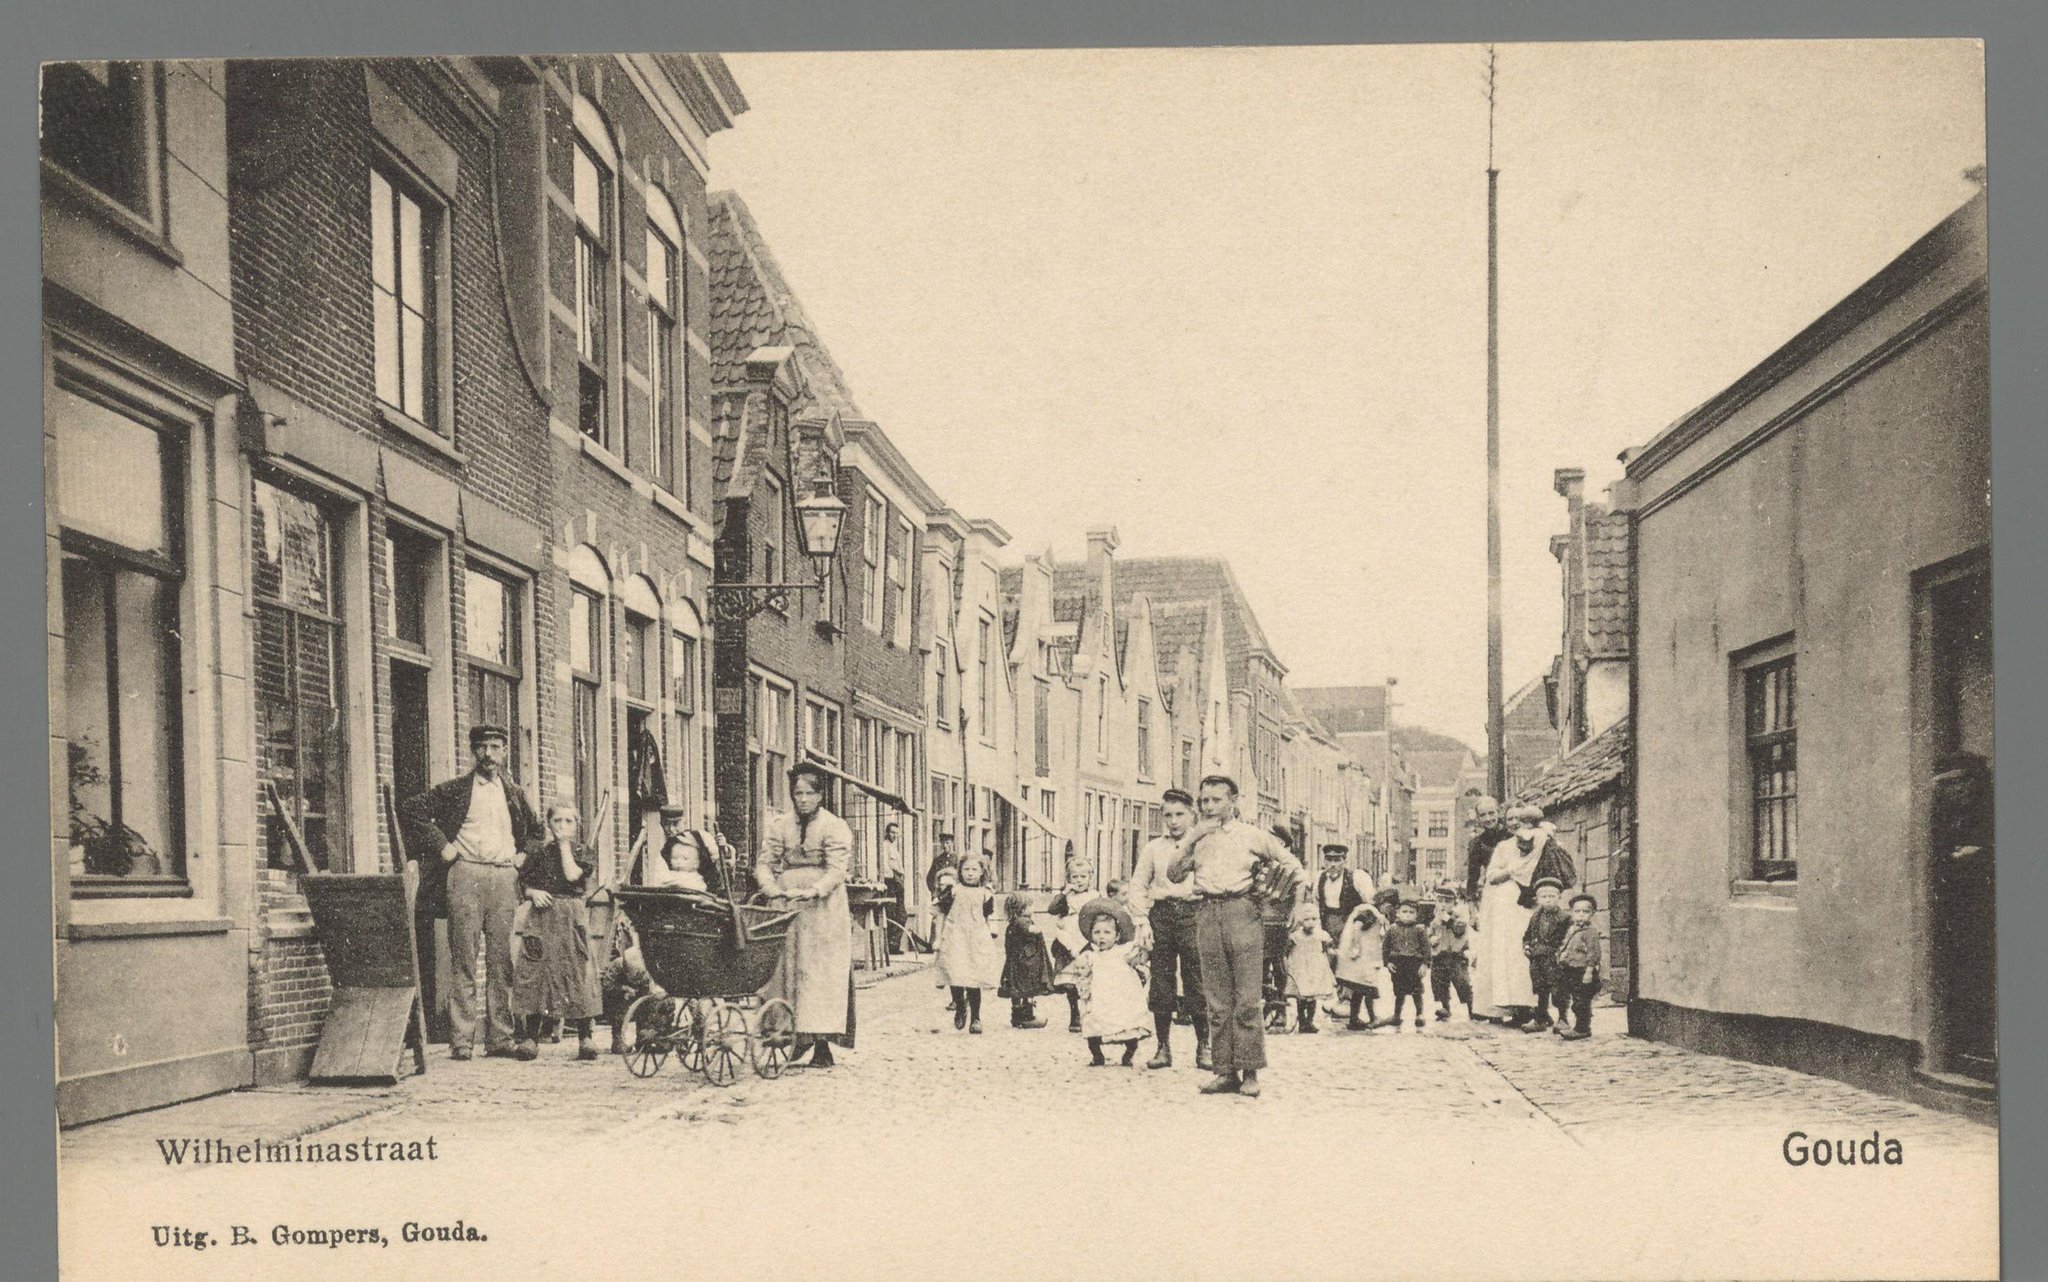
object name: ansichtkaart, prentbriefkaart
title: Wilhelminastraat. Gouda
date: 1897-1905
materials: cardboard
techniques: photograph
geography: gouda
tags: street, gouda